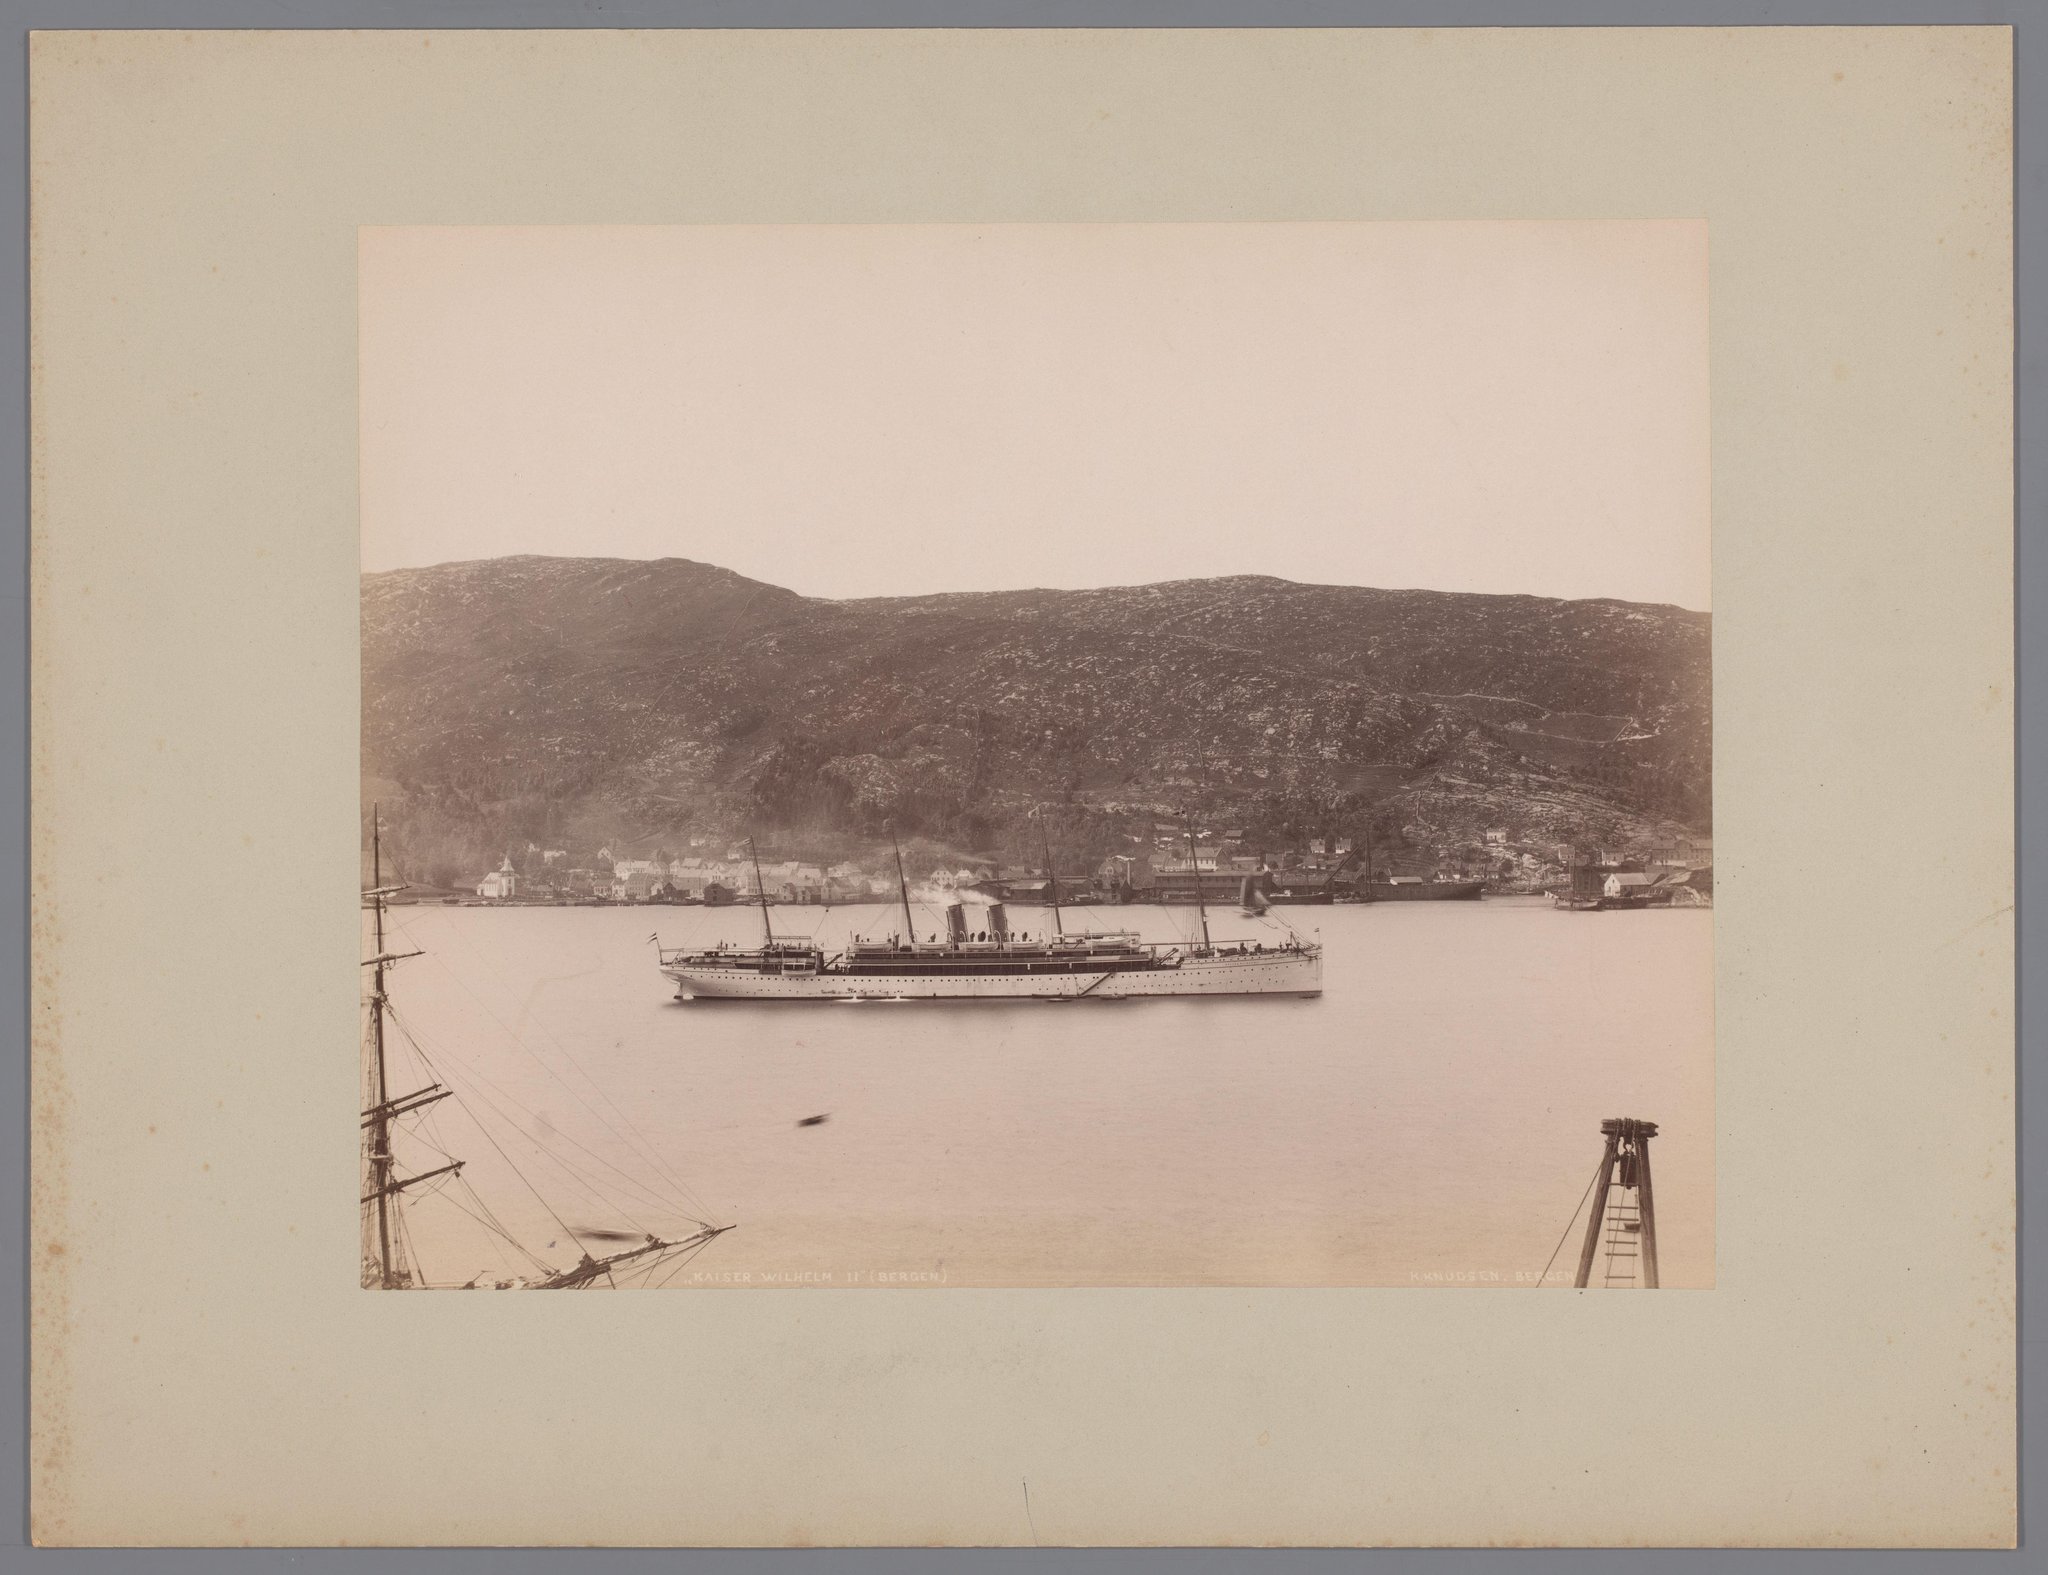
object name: photograph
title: Schip "Kaiser Wilhelm II", Bergen, Noorwegen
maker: knud knudsen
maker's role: fotograaf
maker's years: 1832-1915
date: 1870-1900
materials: cardboard, photographic support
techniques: albumen print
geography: norway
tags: bergen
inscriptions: caption: ‘"Kaiser Wilhelm II" (Bergen)’, signature: ‘K.KNUDSEN, BERGEN’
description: Uitzicht op een meer, met schip en bergen op de achtergrond.